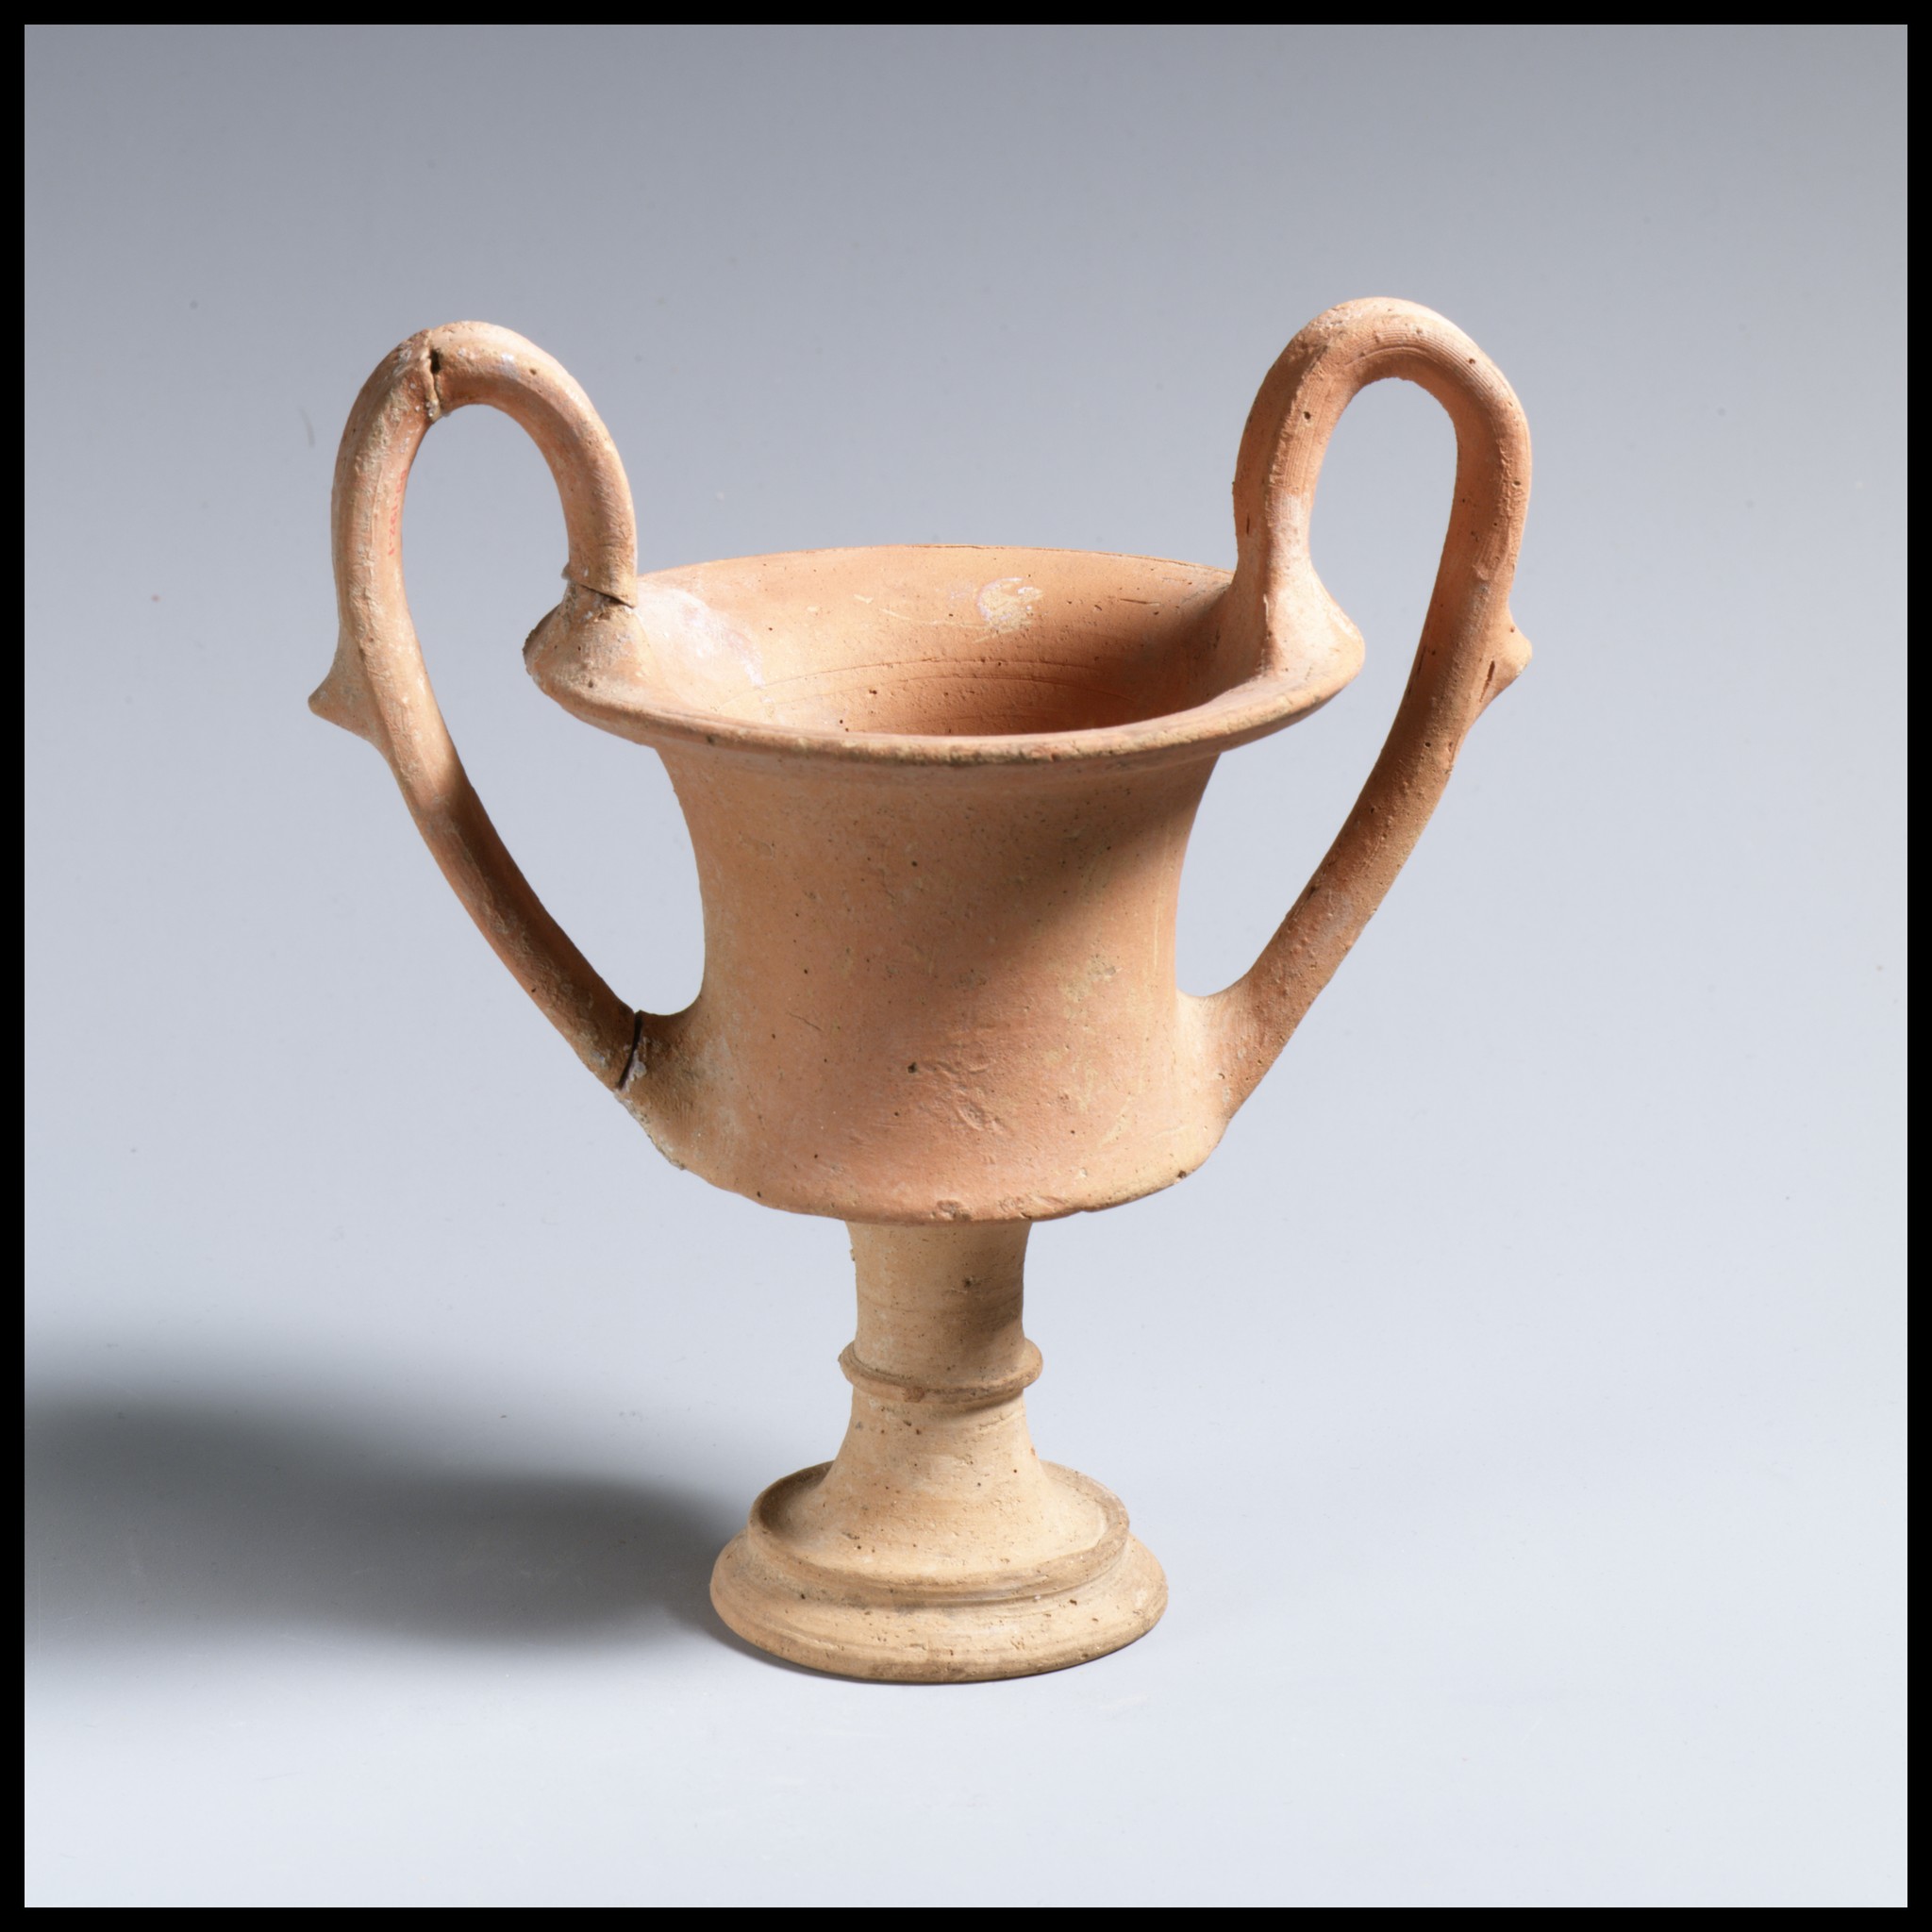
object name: kantharos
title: Terracotta kantharos (drinking cup with high handles)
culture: greek, south italian, apulian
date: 325-300 BCE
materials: terracotta